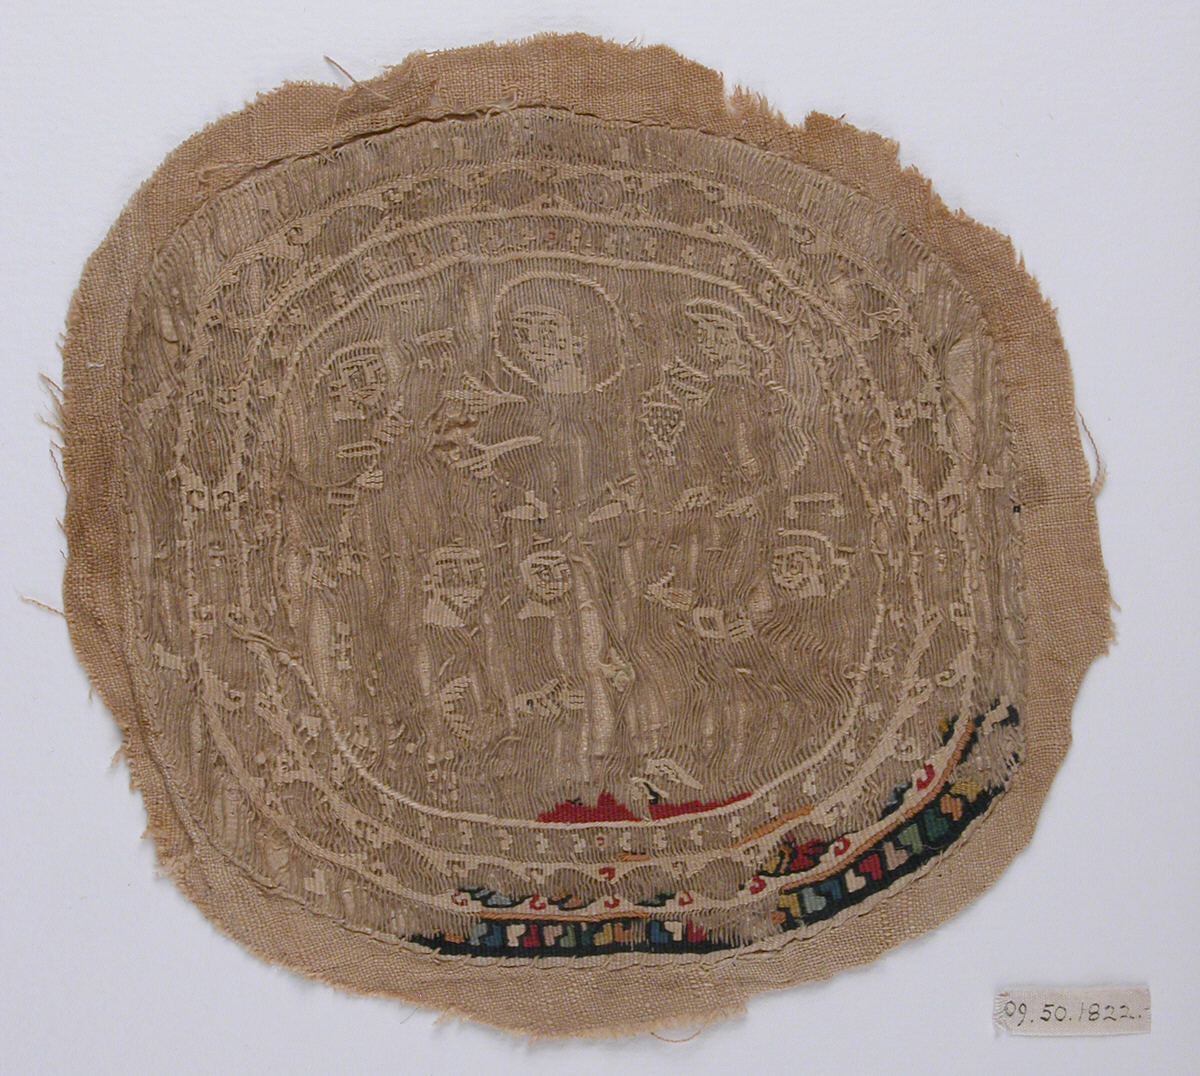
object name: roundel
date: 501-700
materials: linen, wool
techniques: weave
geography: egypt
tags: human figures